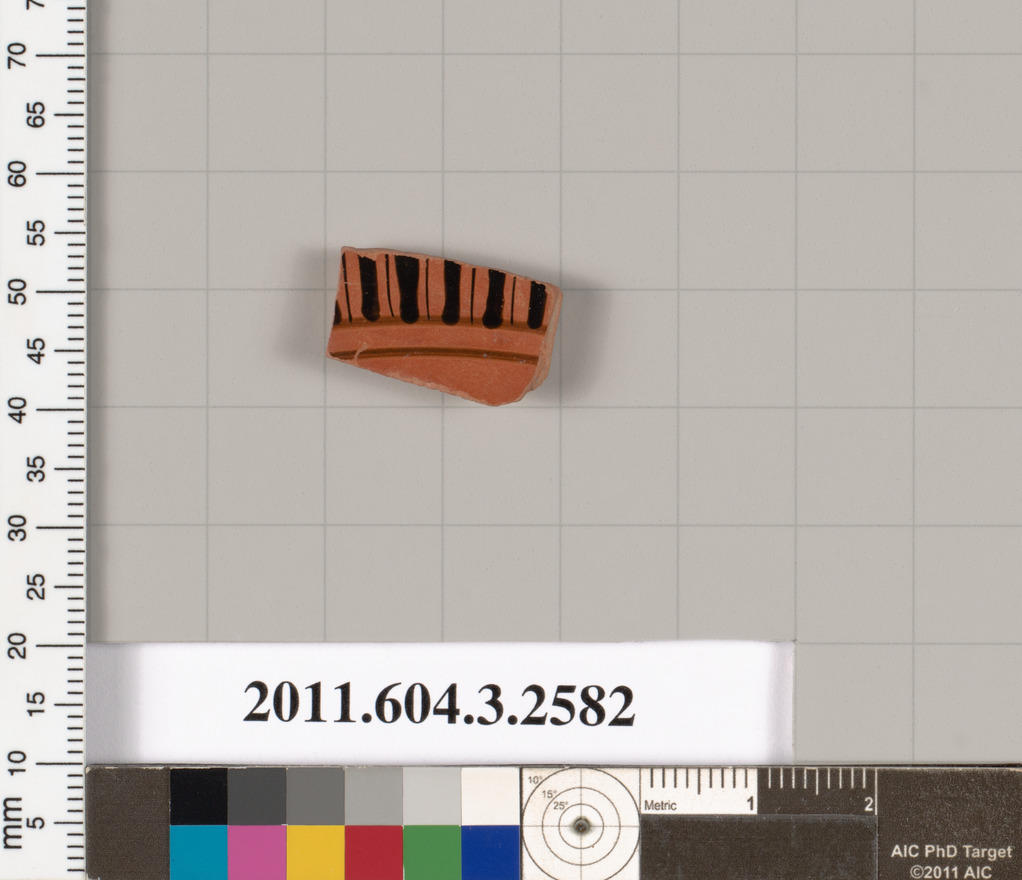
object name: kylix fragment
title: Terracotta fragment of a Little Master cup (drinking cup)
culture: greek, attic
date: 575-551 BCE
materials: terracotta